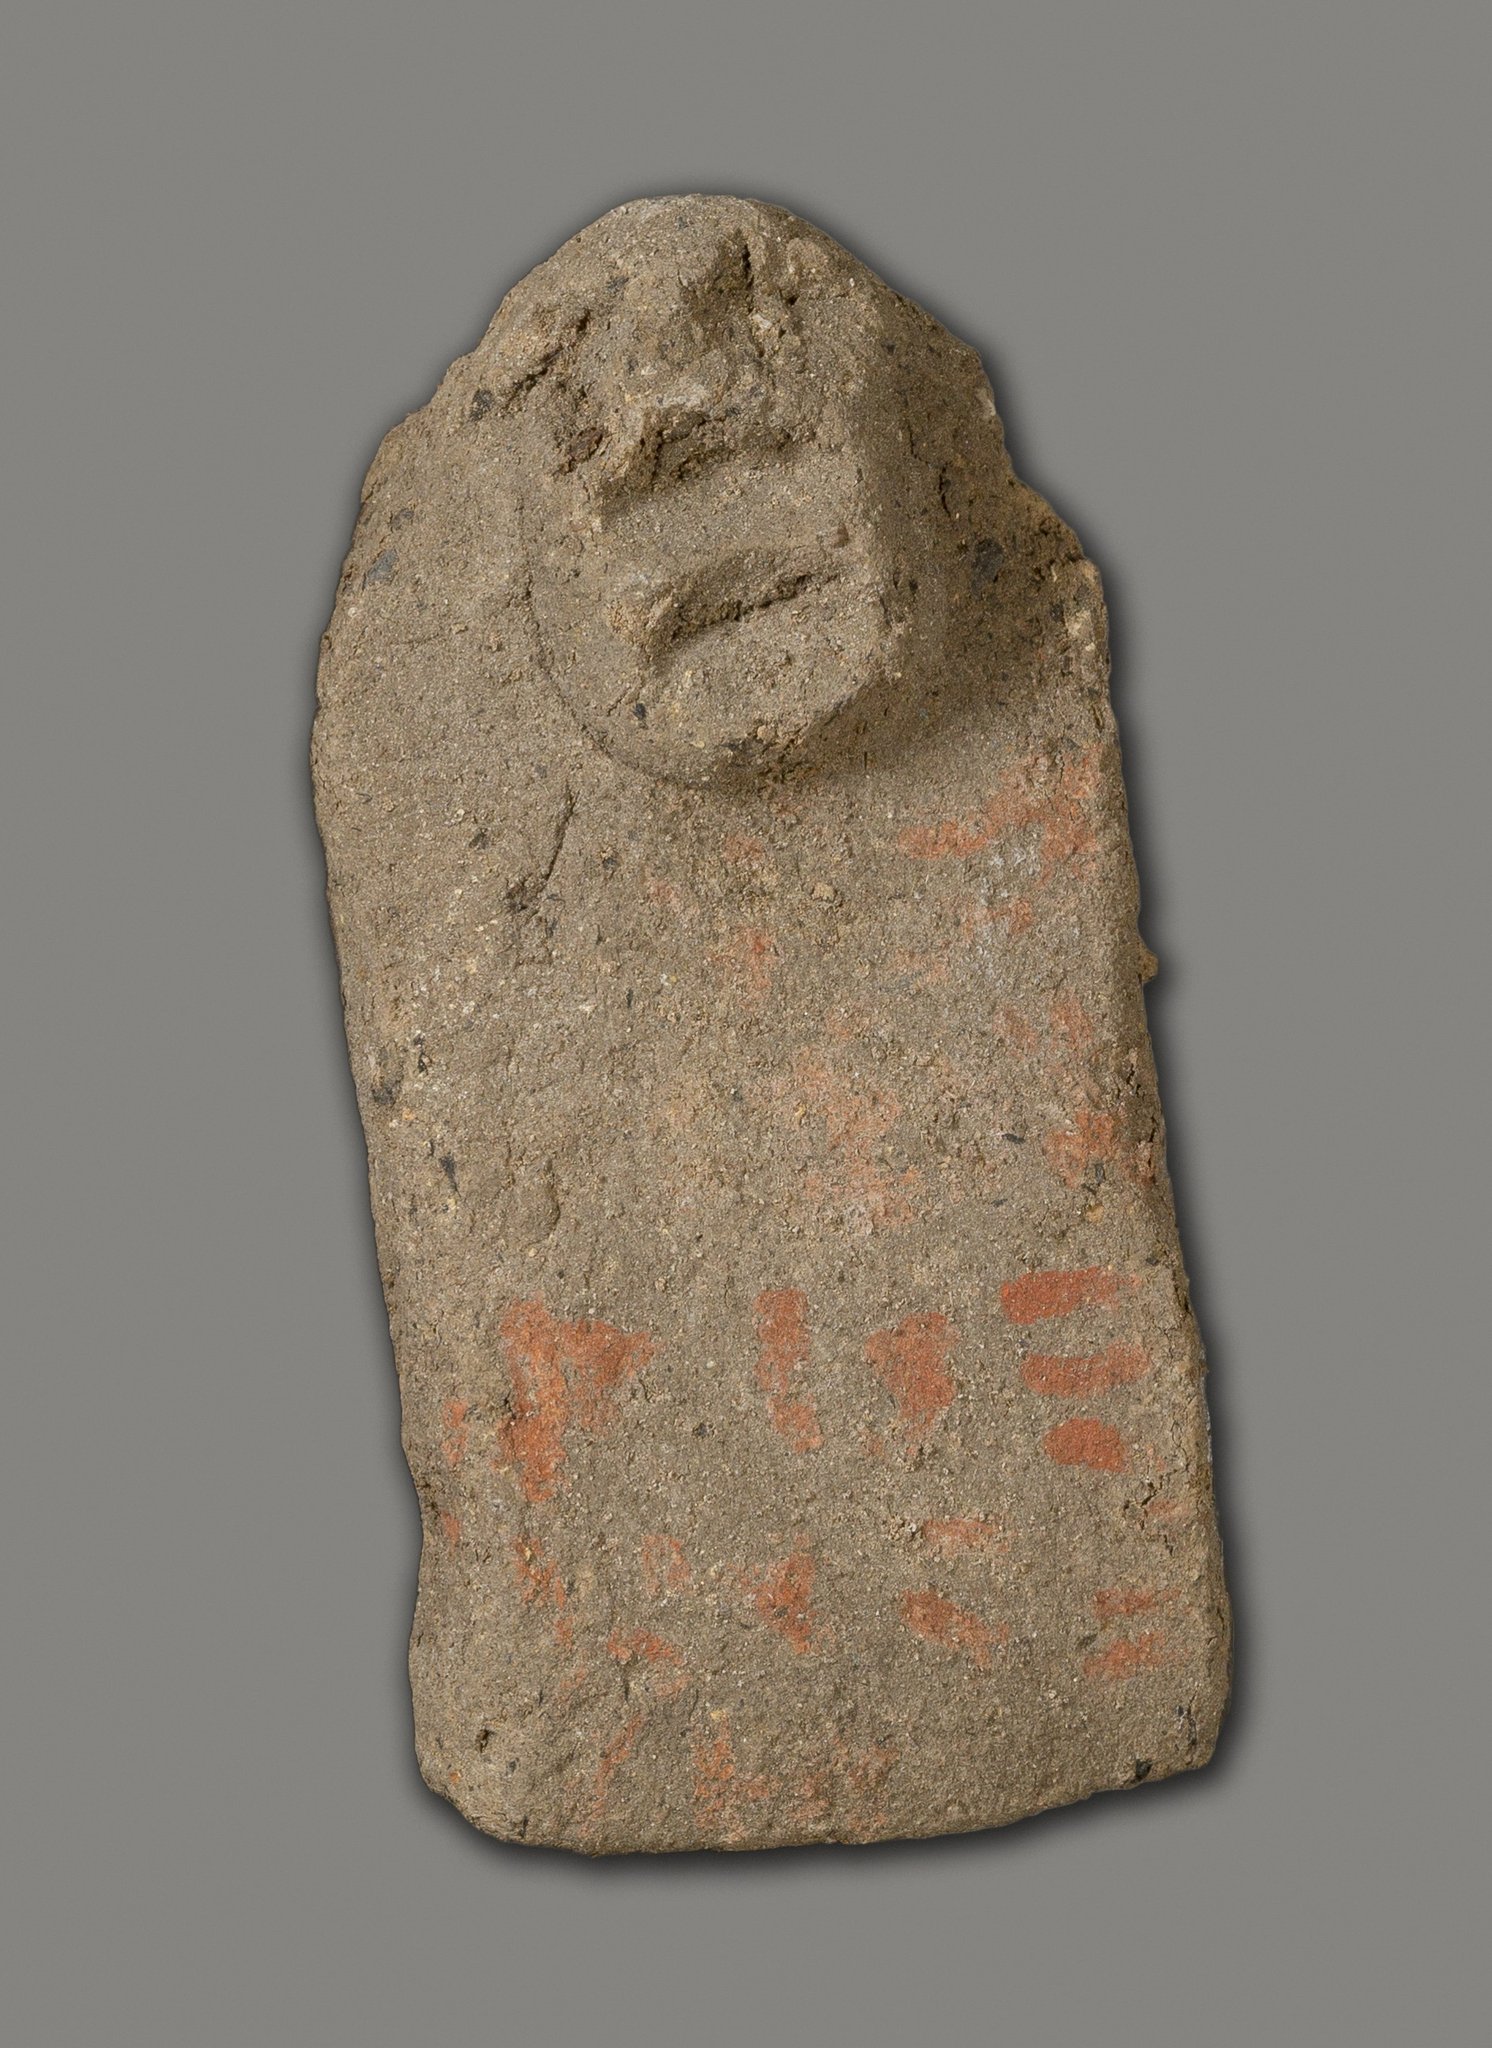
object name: figure, magical, execration, tablet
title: Magical Figure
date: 1802-1550 BCE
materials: clay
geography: egypt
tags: faces